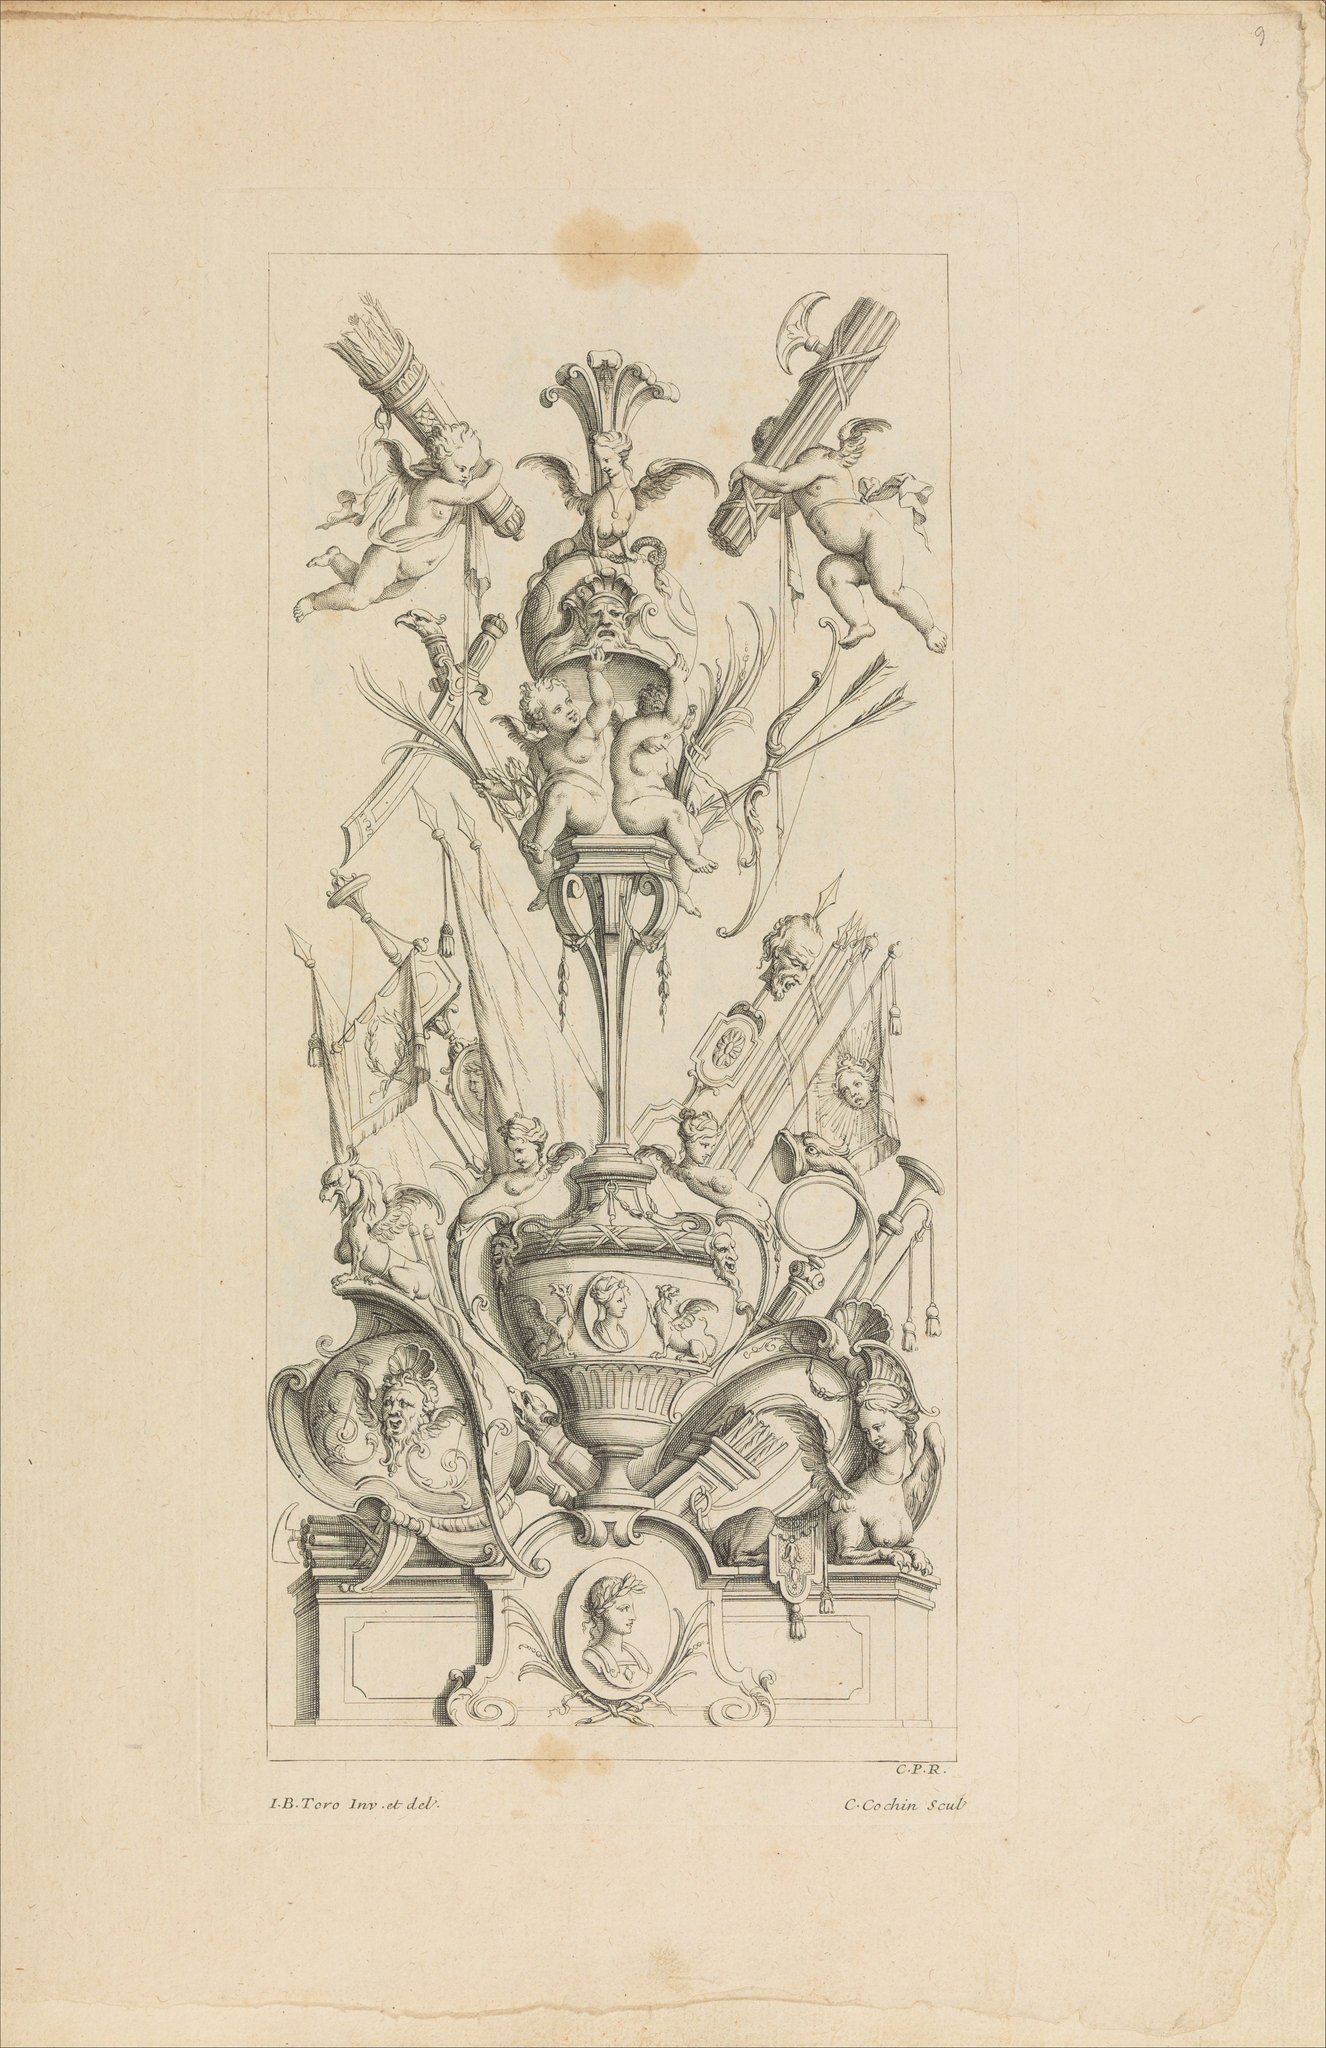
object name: album print ornament architecture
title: Trophées Nouvellement Inventez par J.B. Toro.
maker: jean bernard toro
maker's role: designer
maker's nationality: french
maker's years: 1672-1731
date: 1716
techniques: etching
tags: ornament,mythical creatures,putti,trophies